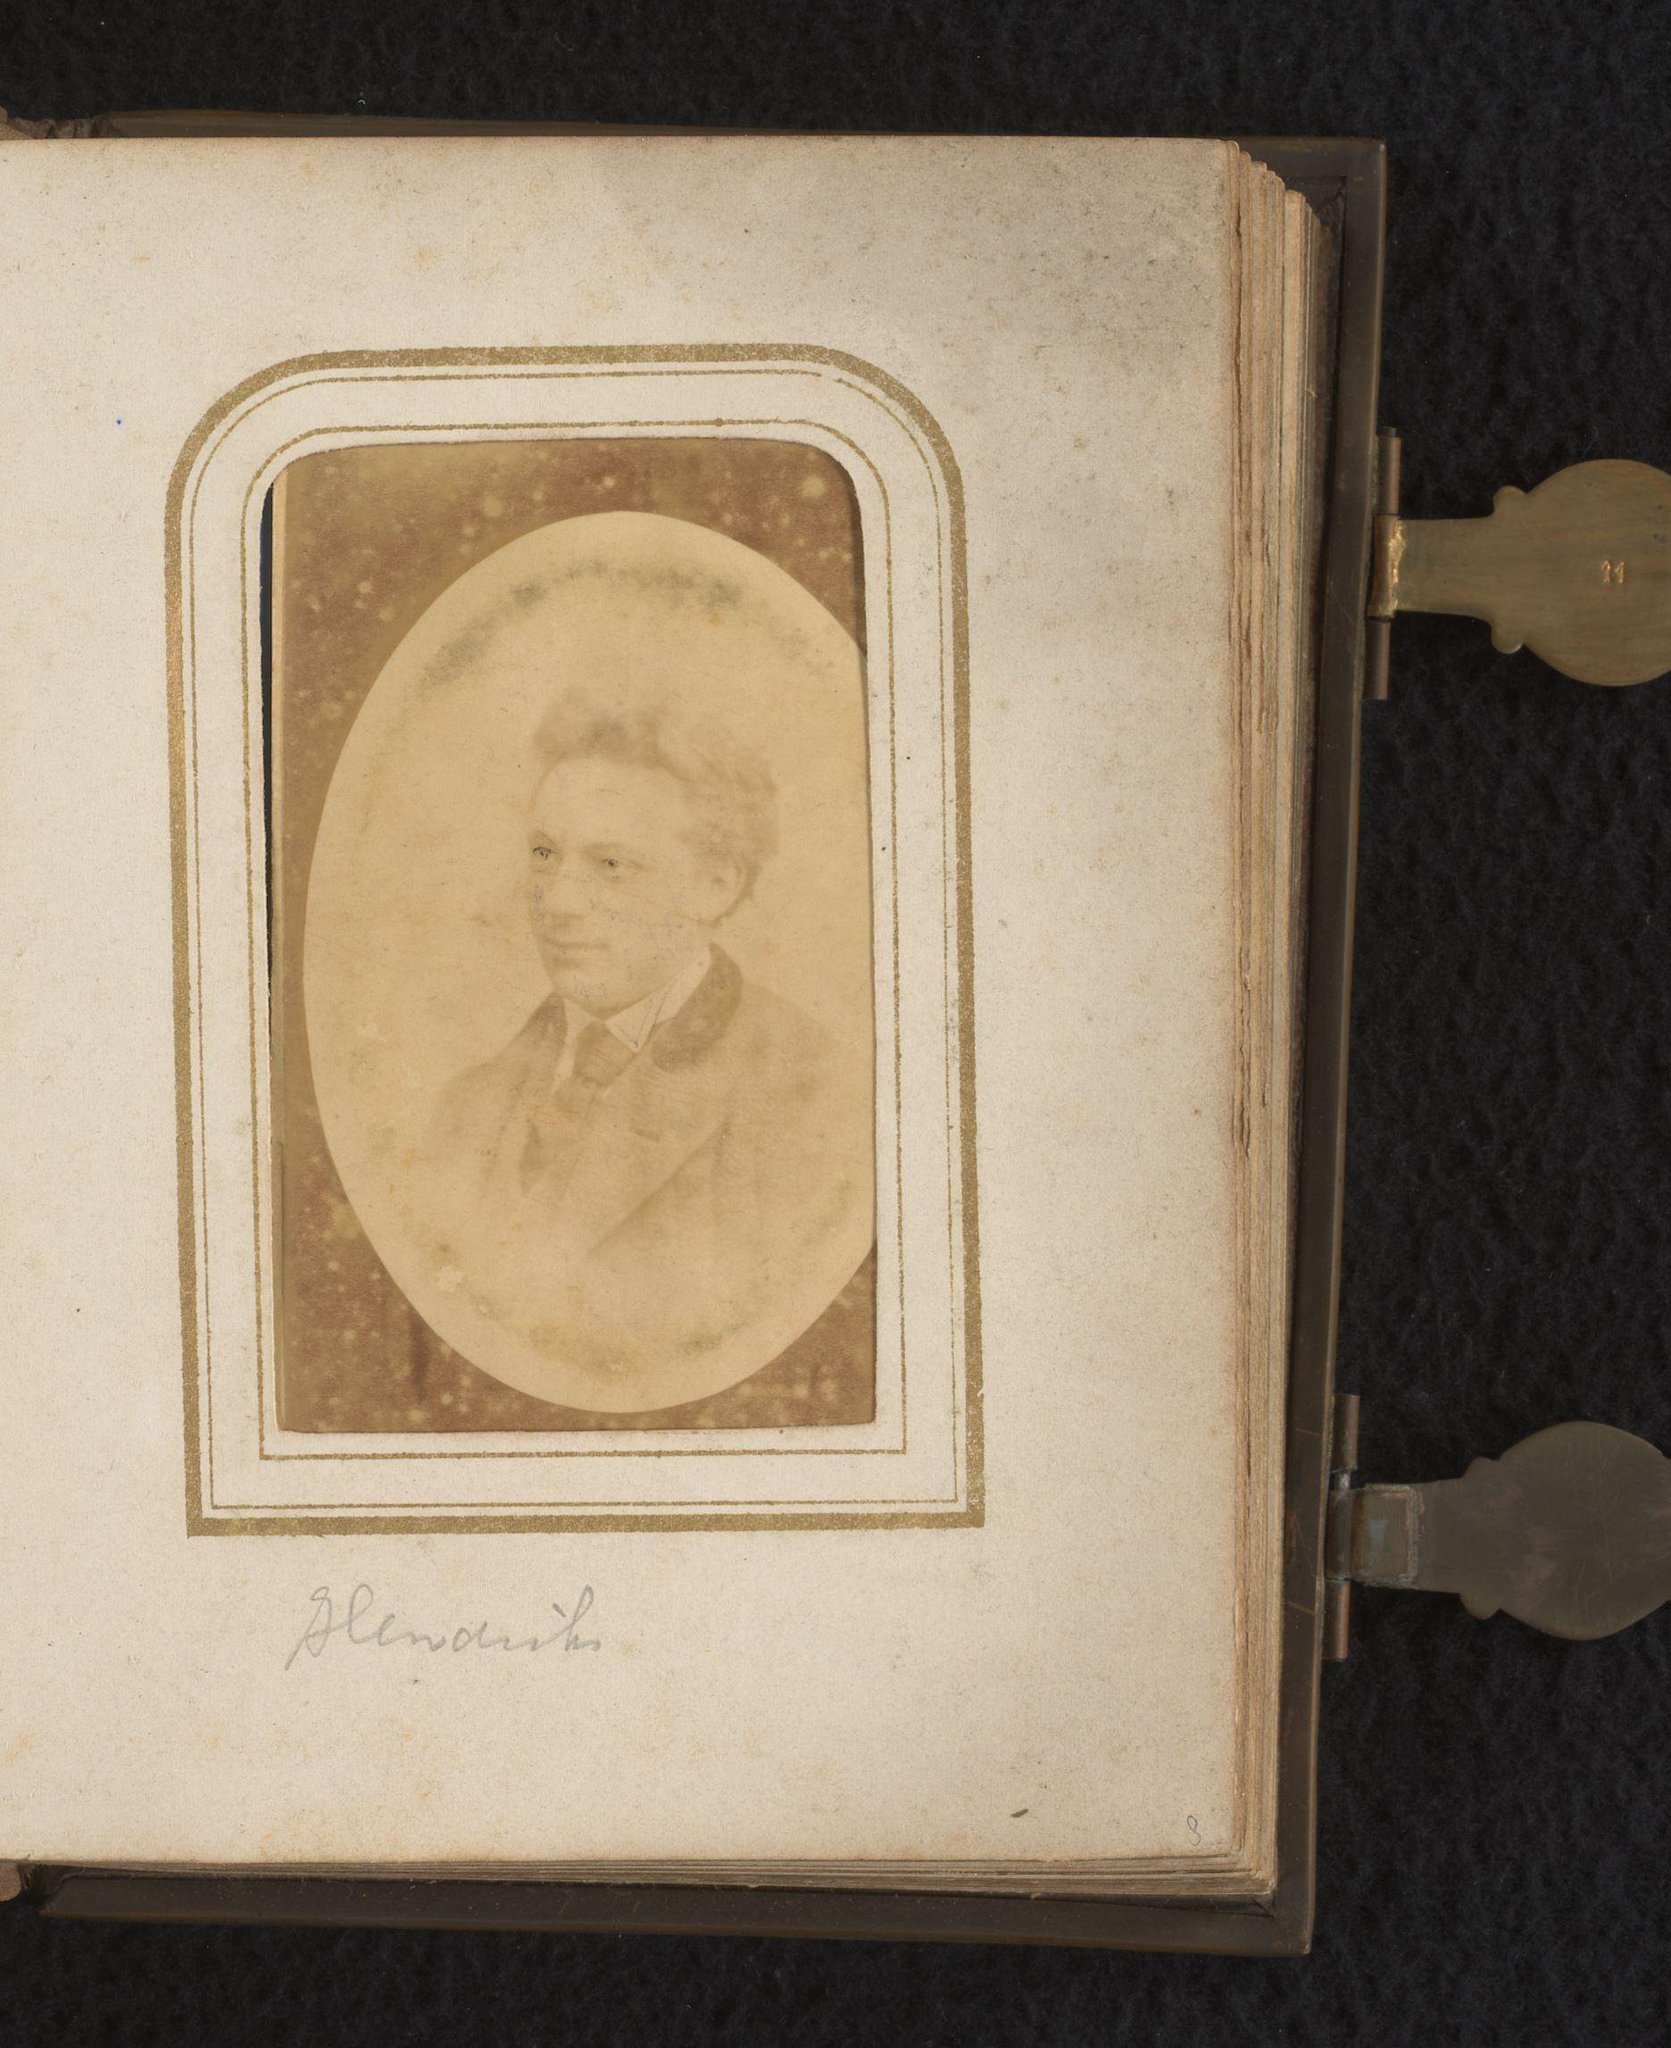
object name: photograph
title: Portret van een man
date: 1854-1865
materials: cardboard, photographic support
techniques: albumen print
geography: maastricht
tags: adult man, historical persons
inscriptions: inscription: ‘P. Weynen & Fils.’, annotation: ‘Hendriks’, annotation: ‘Hendriks’